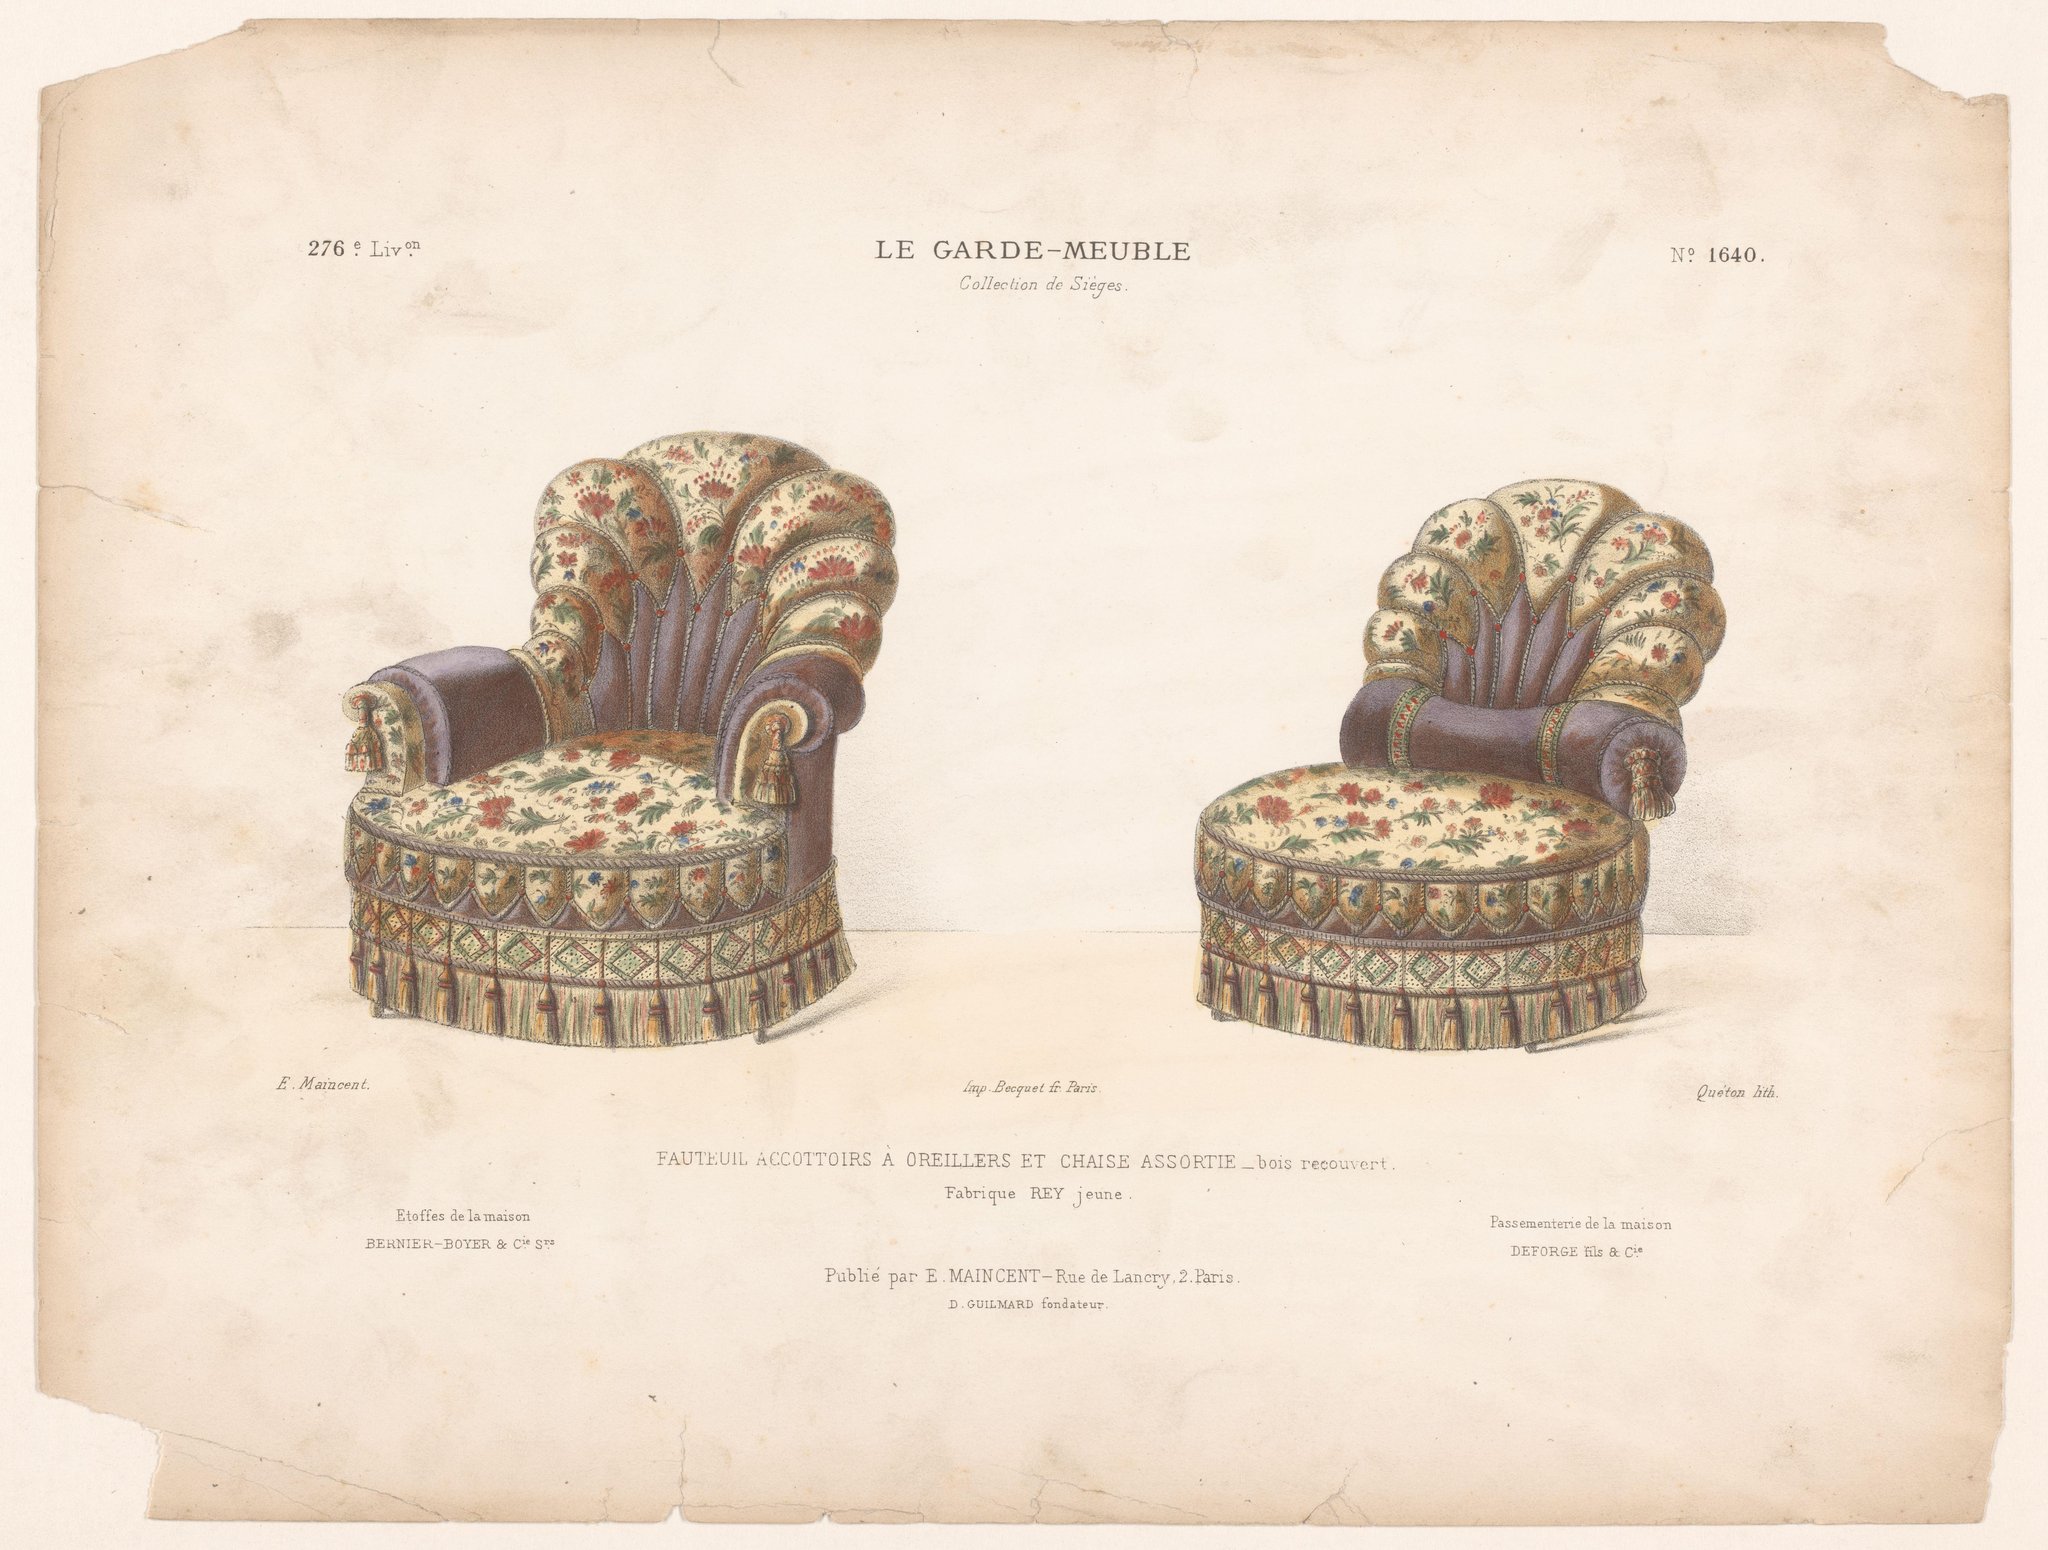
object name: print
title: Fauteuil en stoel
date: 1885-1895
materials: paper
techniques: hand coloring, lithograph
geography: paris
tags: seating furniture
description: Ieder Livraison in de serie Le Garde-Meuble bevat negen platen: drie 'sièges' (zitmeubels), drie 'meubles' (diverse meubels zoals tafels en kasten) en drie 'tentures' (gordijnen en draperieën).